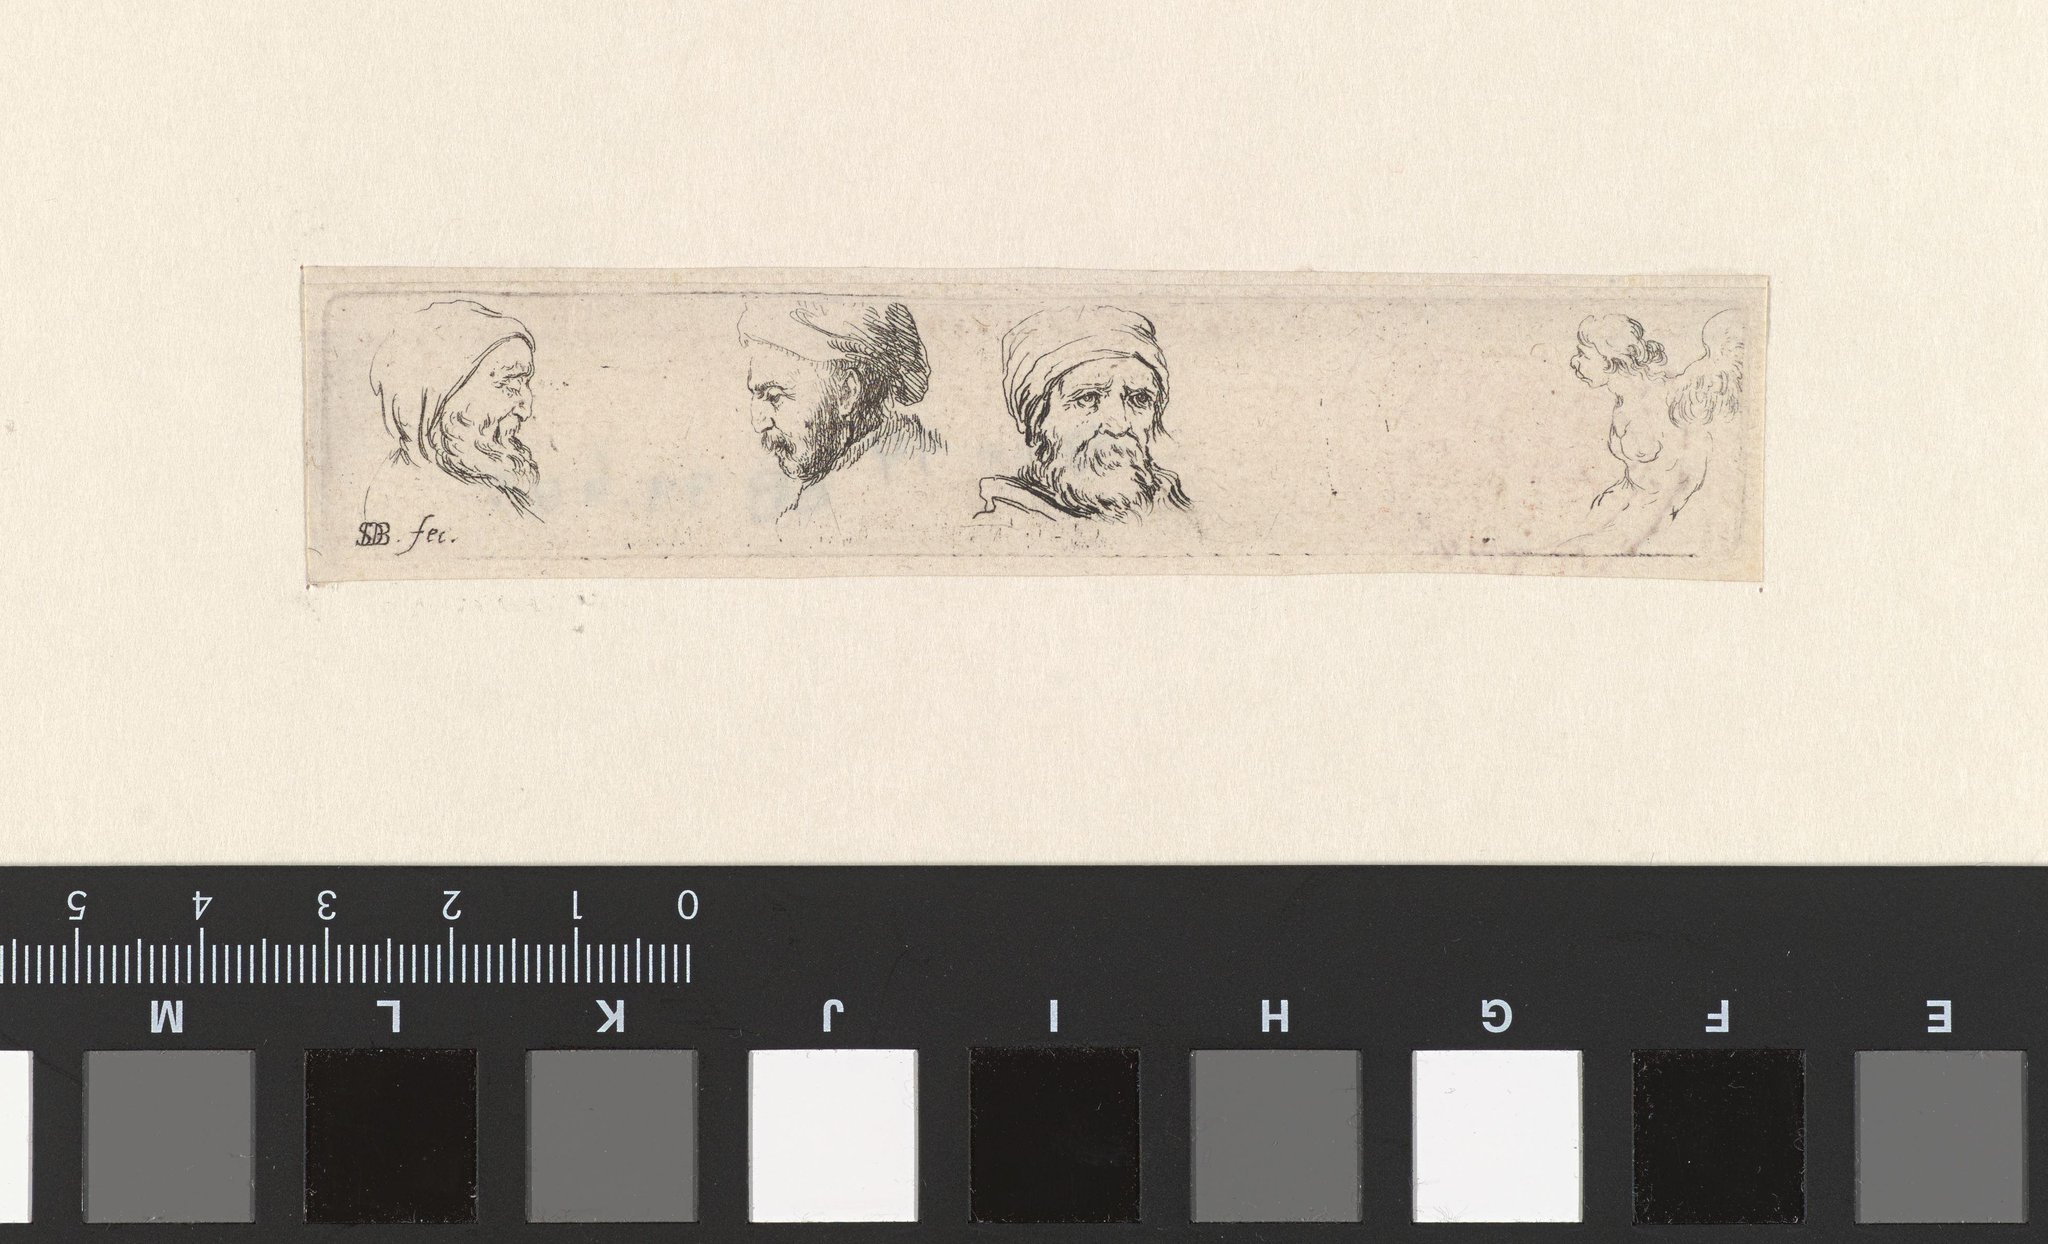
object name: print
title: Drie hoofden van oude mannen en een gevleugelde vrouw ten halven lijve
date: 1620-1657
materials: paper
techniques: etching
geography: france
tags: fabulous beings with wings - aa - female human figure, head (human) (+ three-quarter view), head (human) (+ sideview, profile), old man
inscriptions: collector's mark: Lugt 240